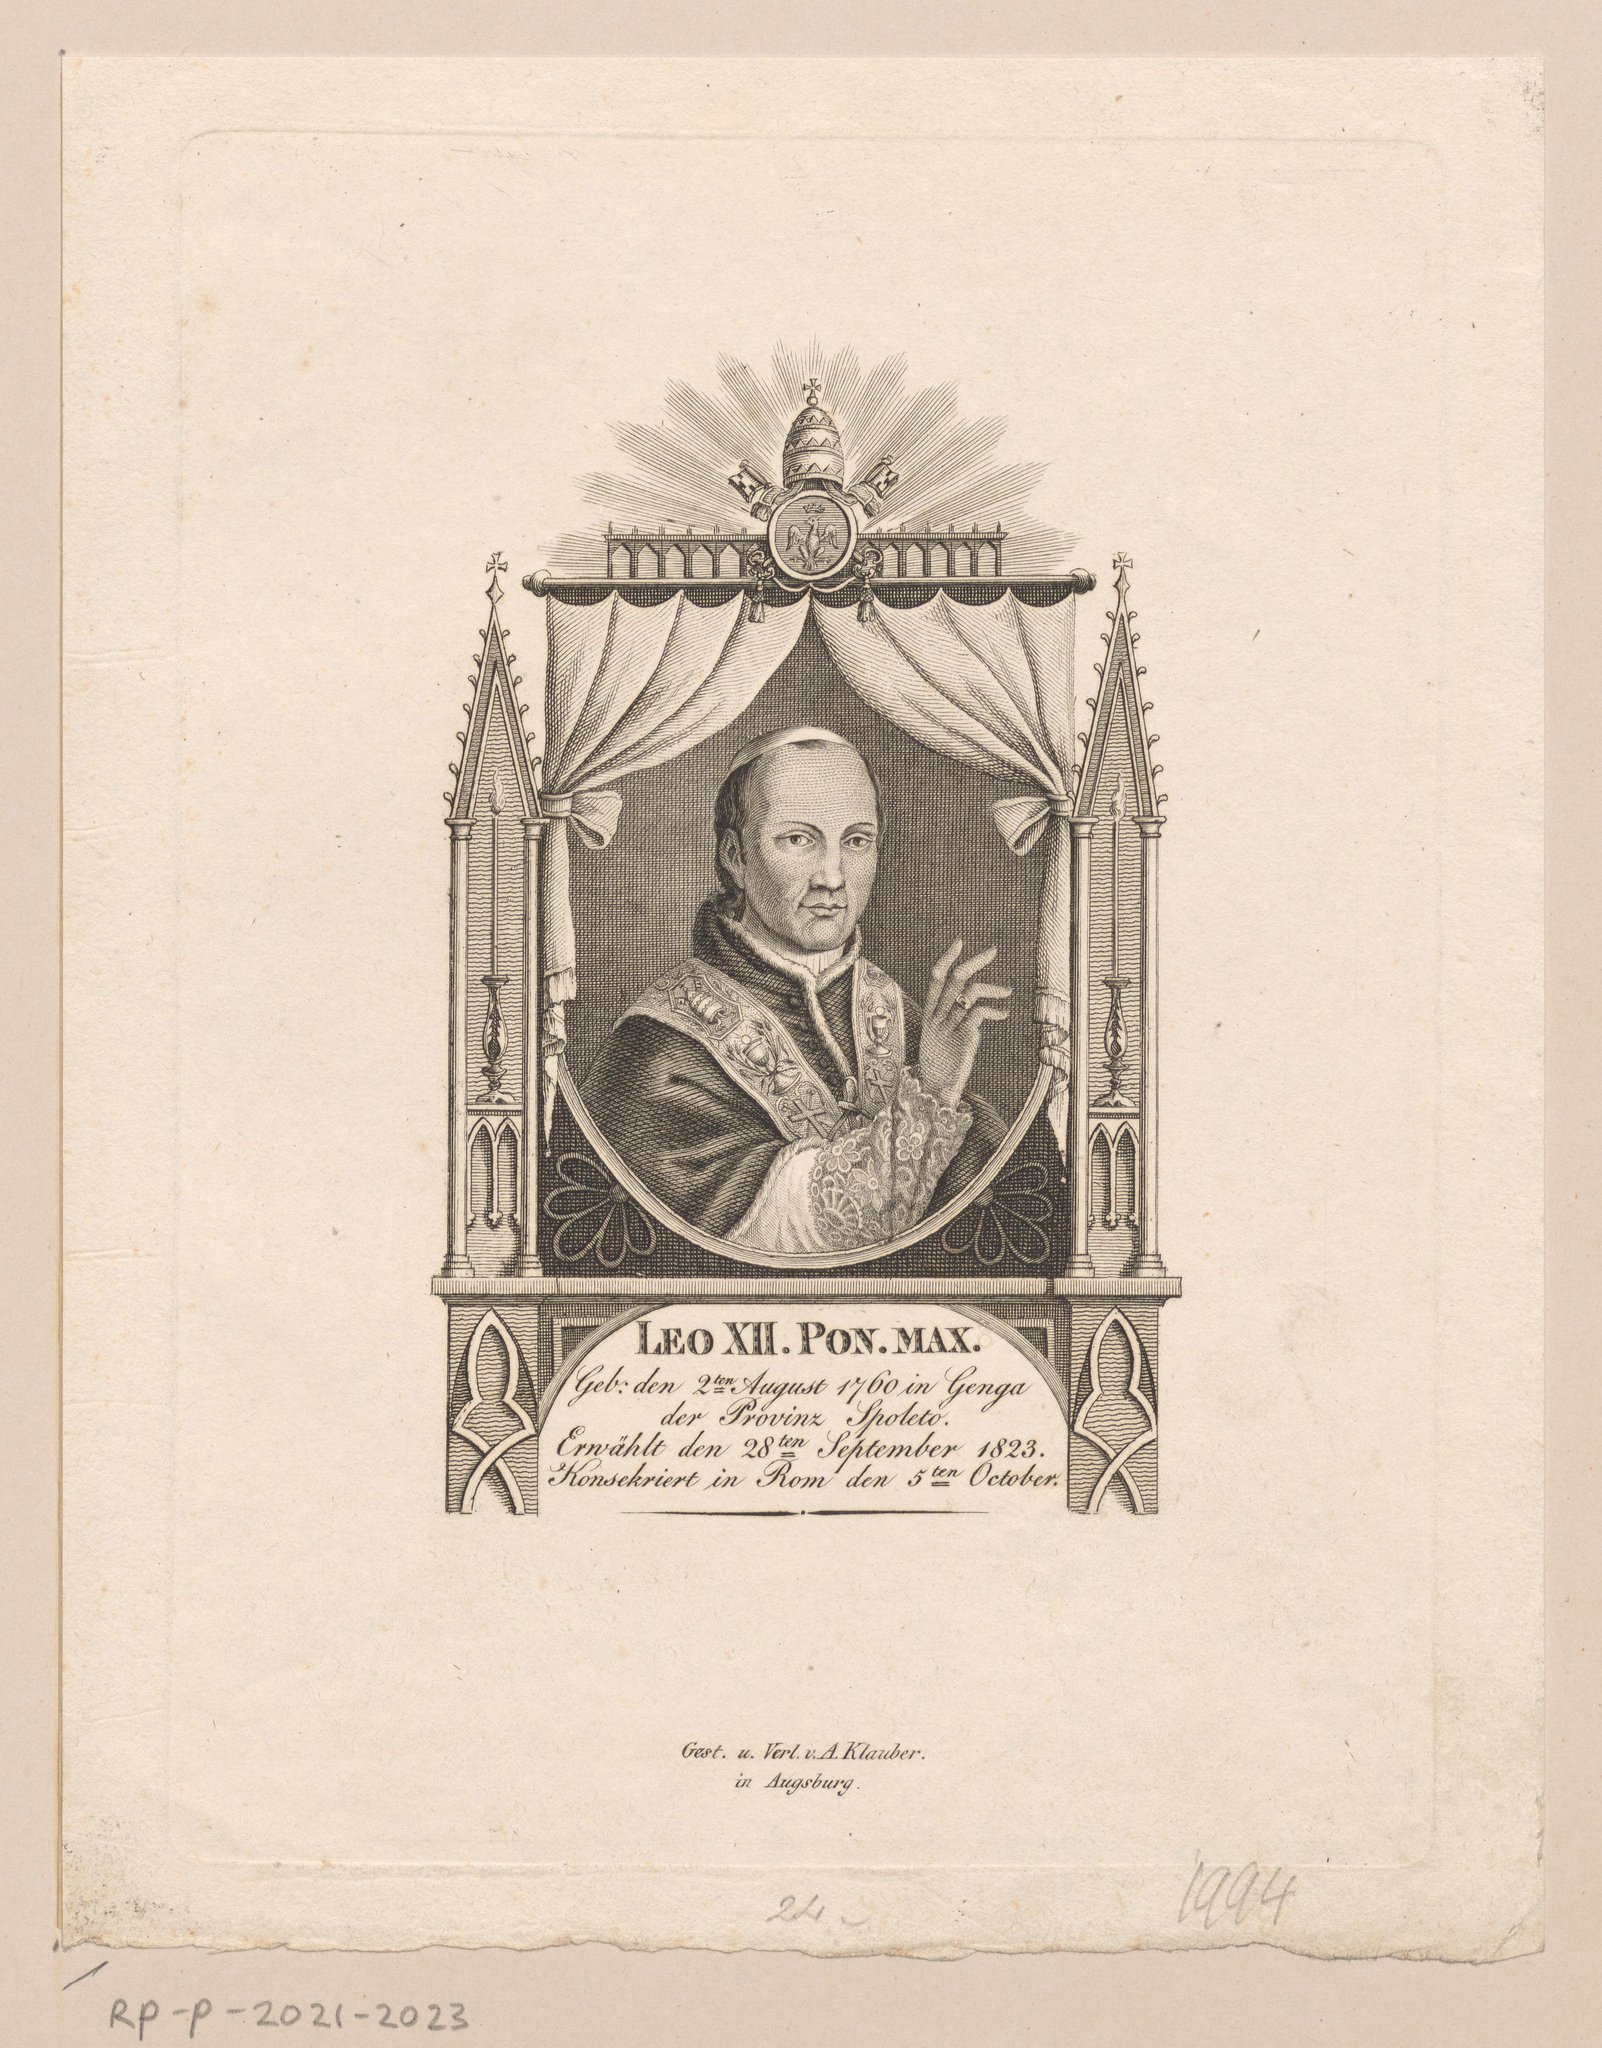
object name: print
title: Portret van paus Leo XII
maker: joseph anton klauber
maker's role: print maker, publisher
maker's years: 1779-1837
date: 1823-1829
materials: paper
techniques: etching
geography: augsburg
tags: rome, (feigned) picture curtain, insignia of the pope, e.g. tiara, historical persons, pope